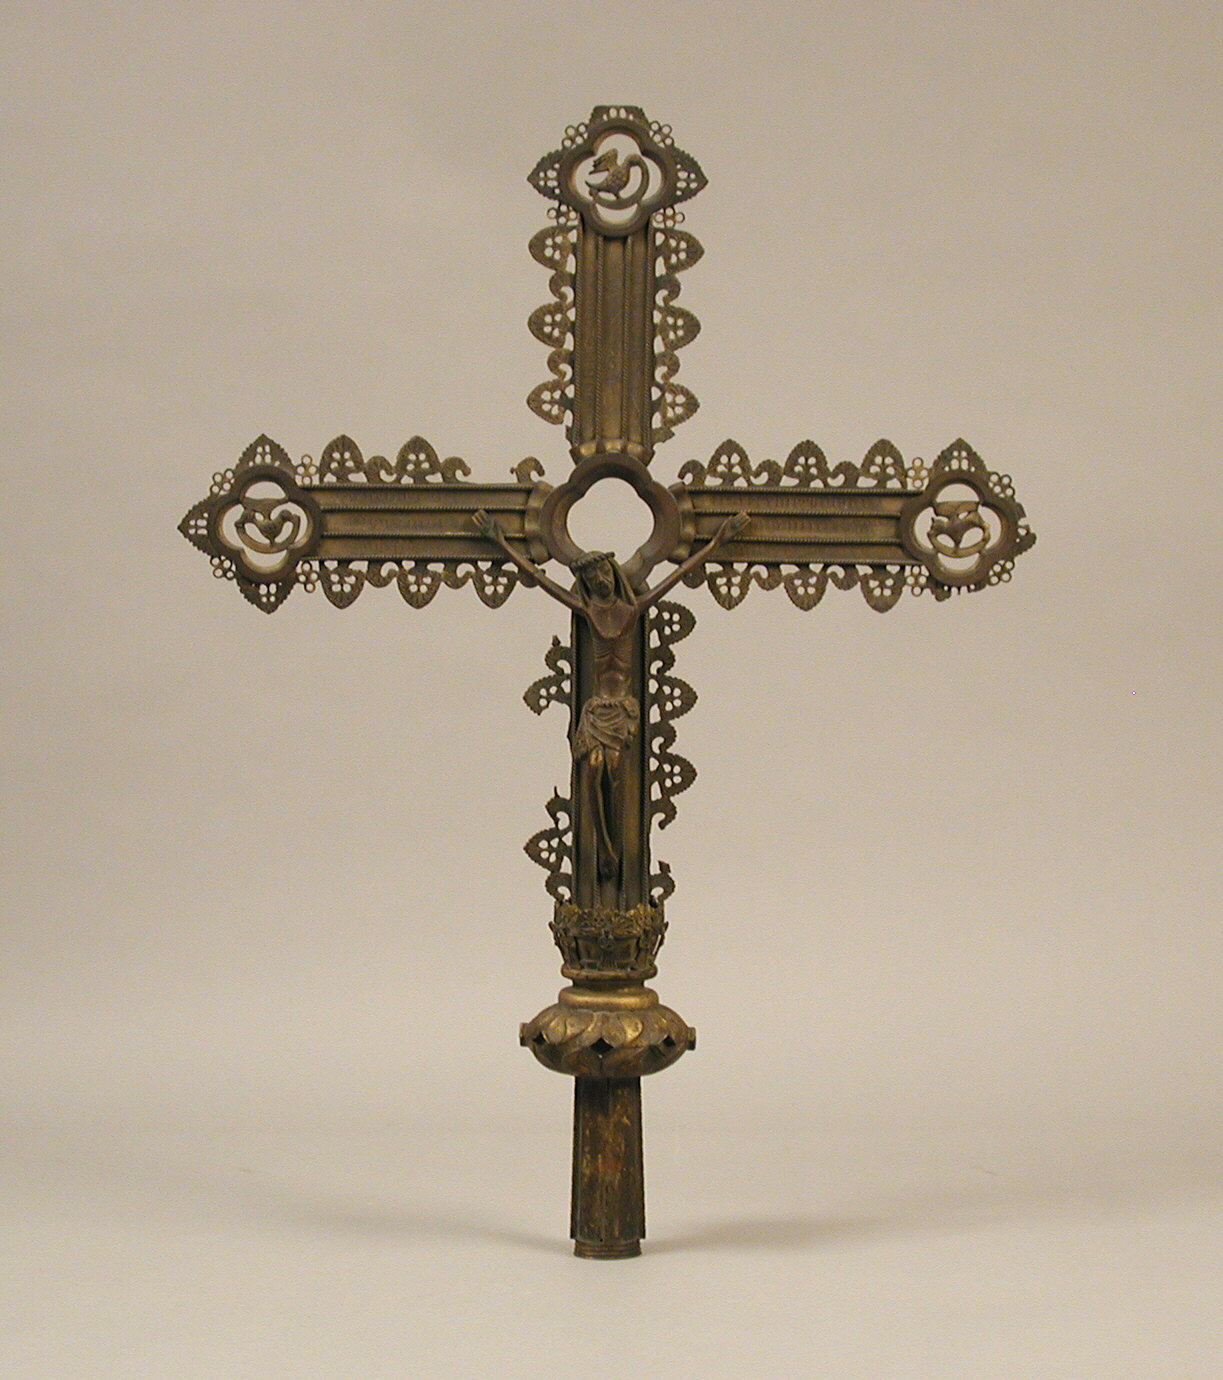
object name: processional cross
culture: irish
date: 1901-1933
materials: brass, gilt